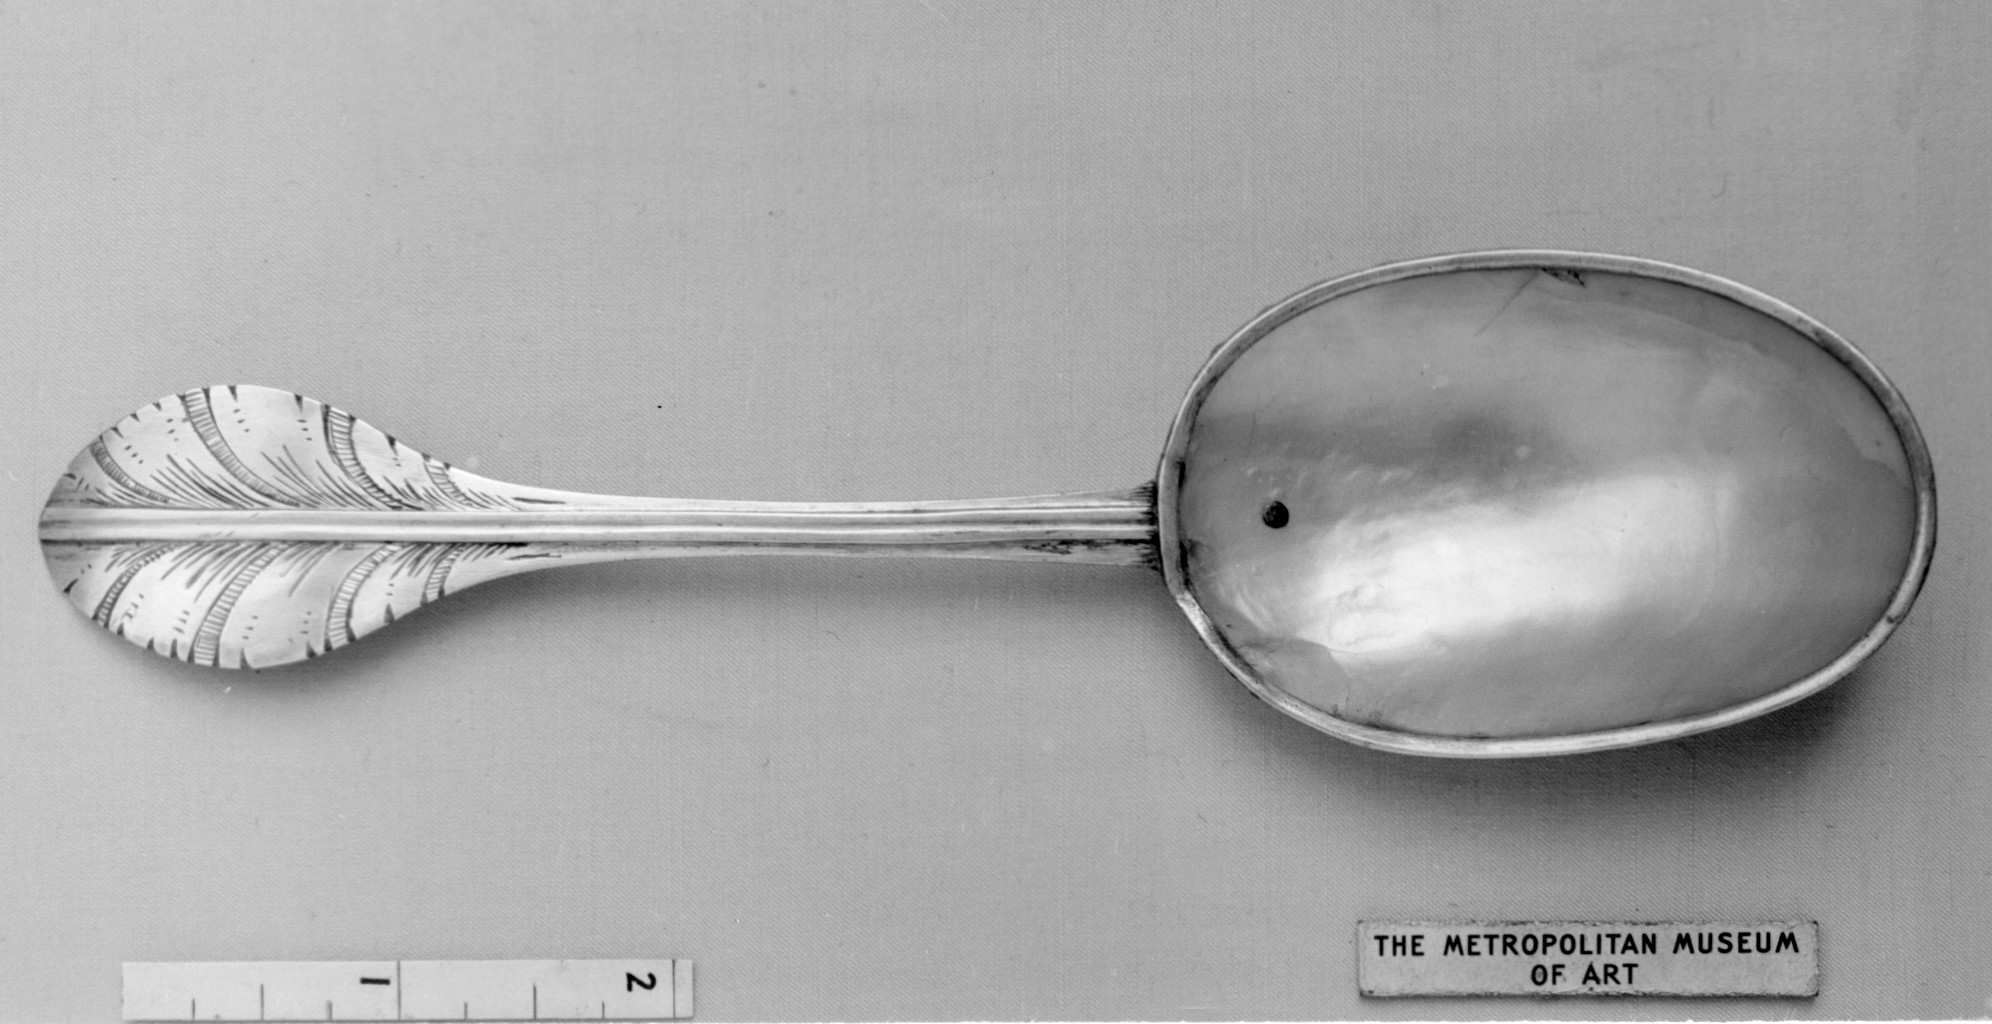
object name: spoon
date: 1701-1800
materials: shell, silver